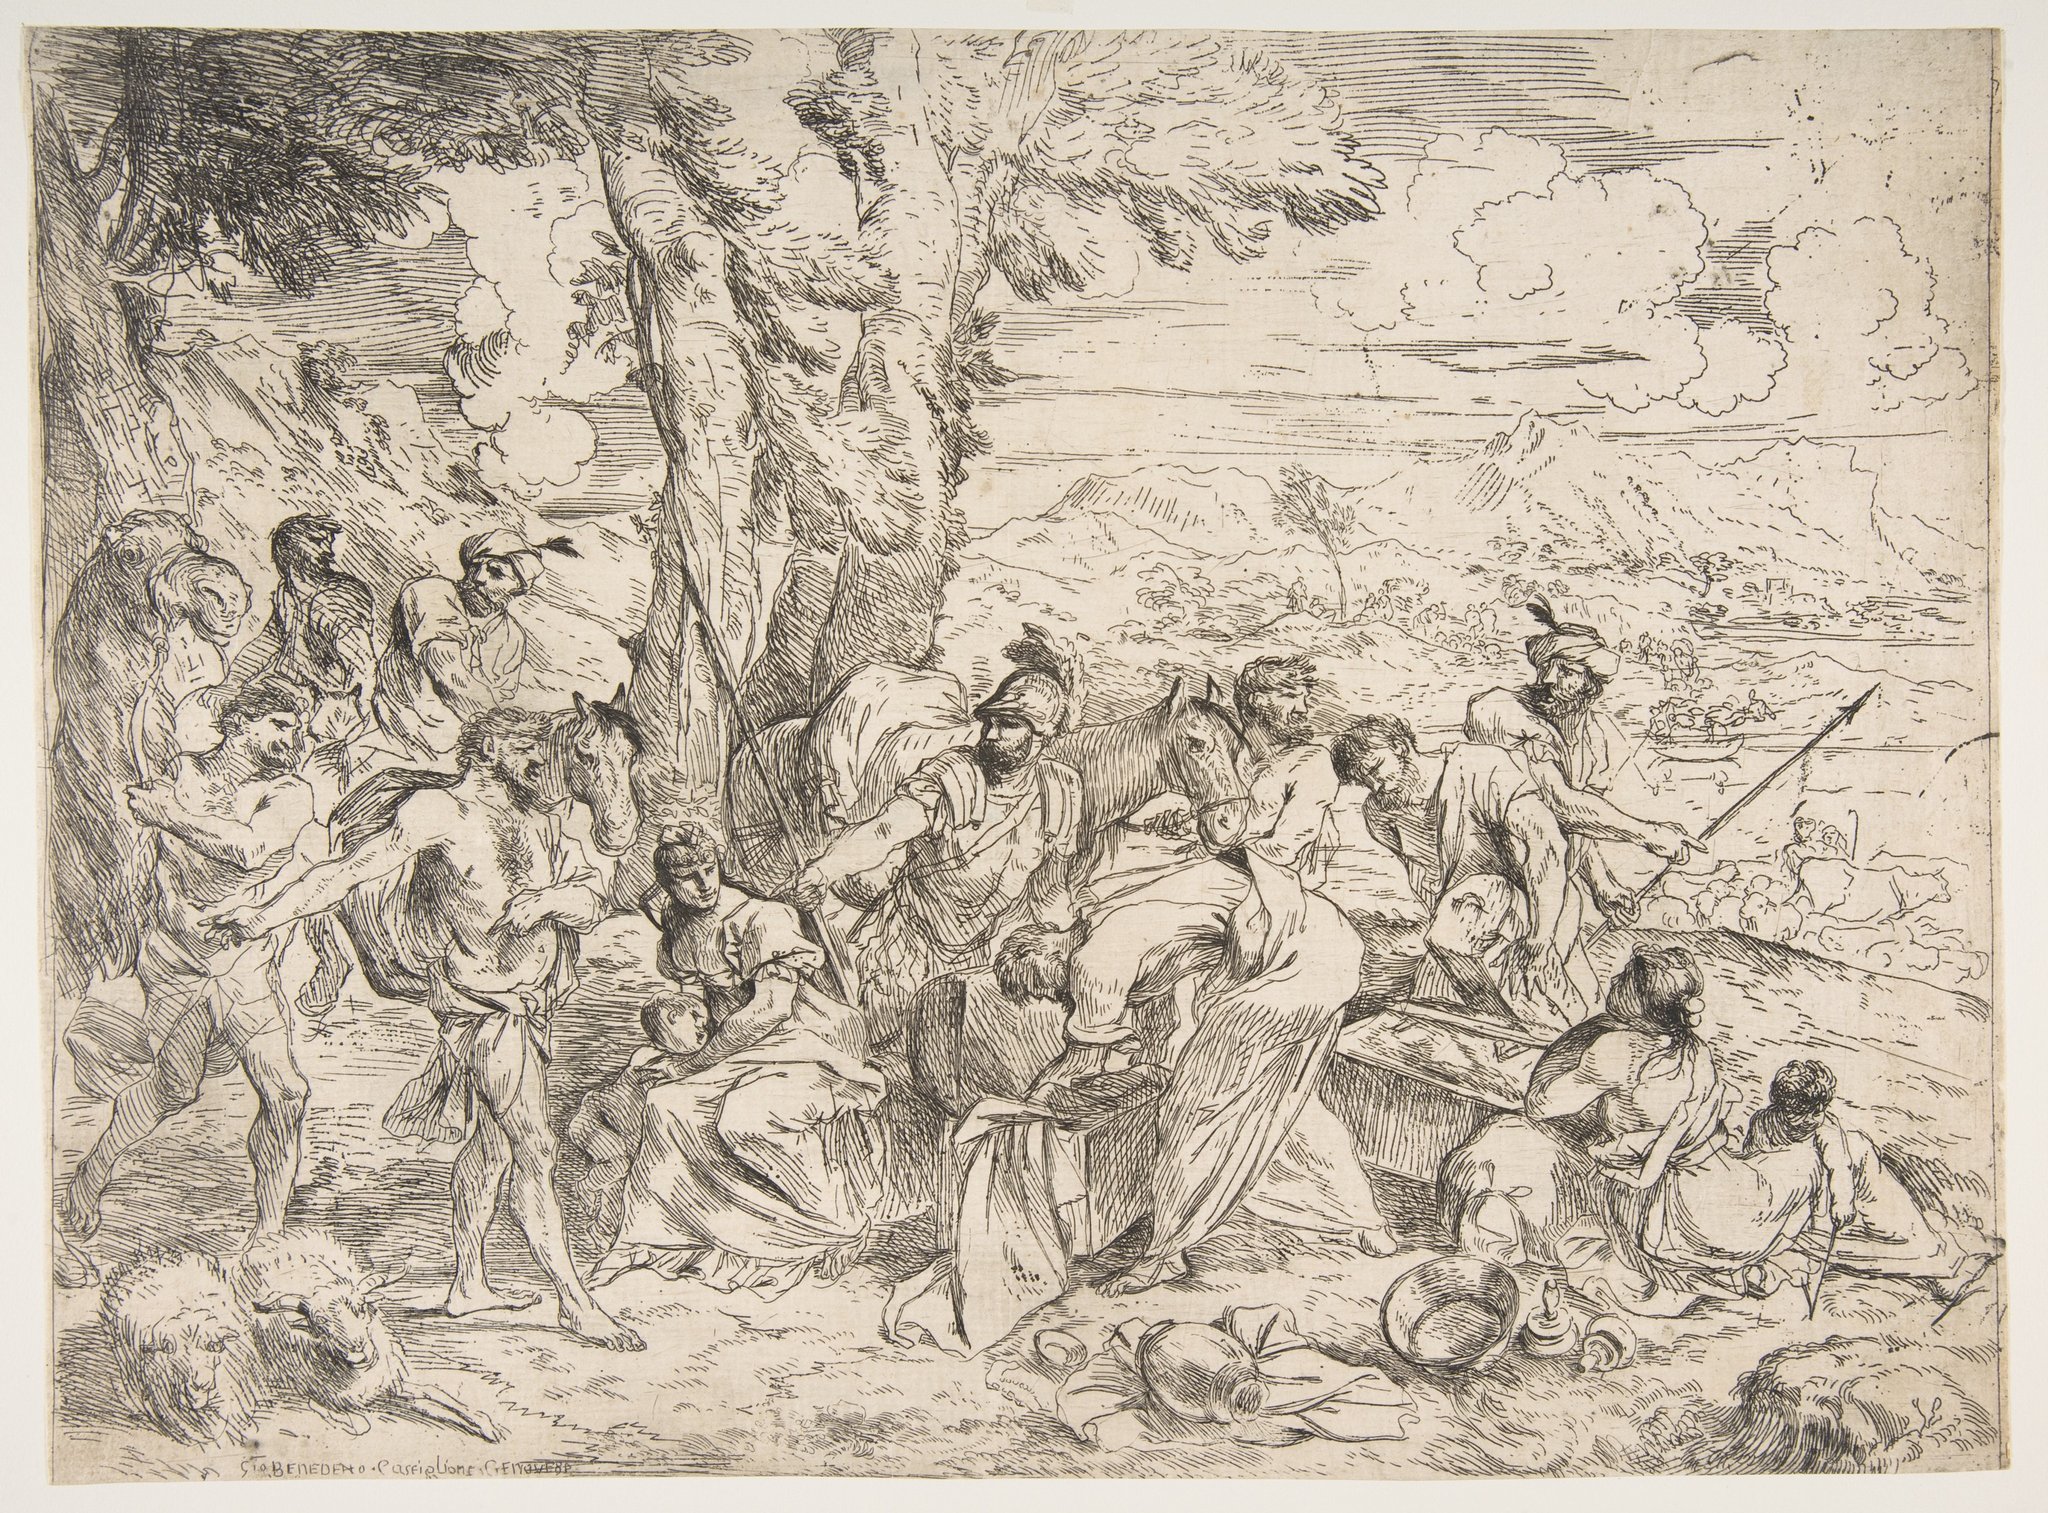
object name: print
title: Laban searching for idols among Jacob's possessions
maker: giovanni benedetto castiglione (il grechetto)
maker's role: artist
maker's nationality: italian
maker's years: 1609-1664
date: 1635-1640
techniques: etching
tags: children,men,women,horses